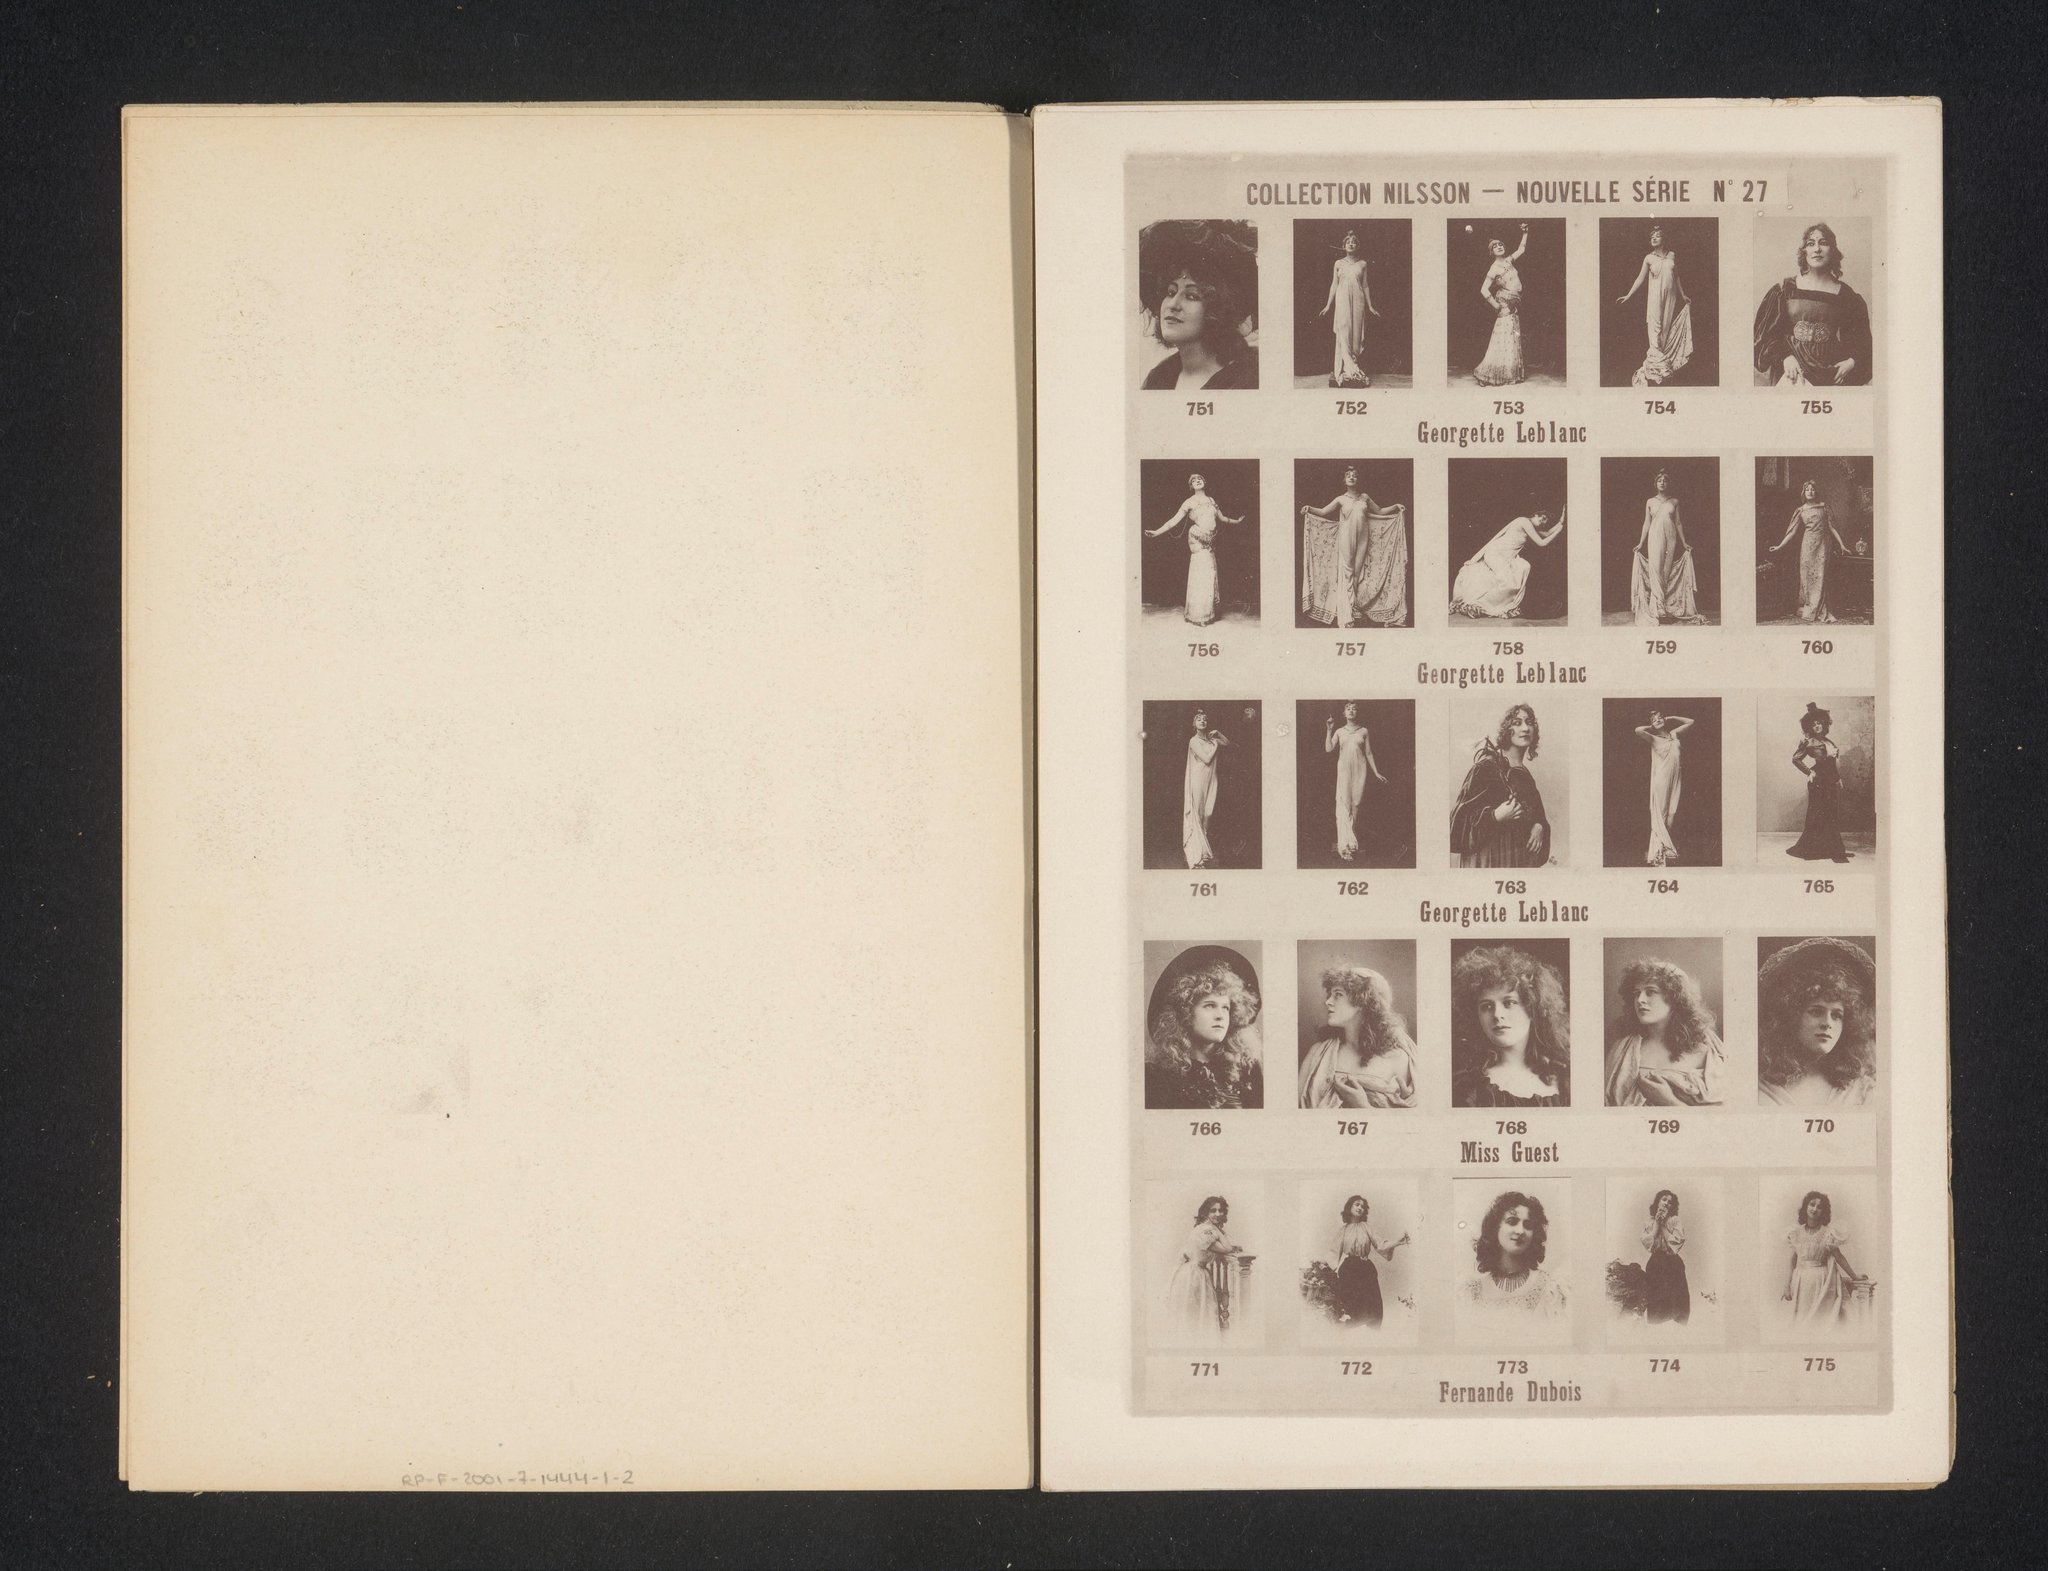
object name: photomechanical print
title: Collection Nilsson - Nouvelle Série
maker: Anonymous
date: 1892-1897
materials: paper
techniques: photograph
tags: historical persons - bb - woman, portrait of actor, actress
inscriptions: number: ‘No 27’